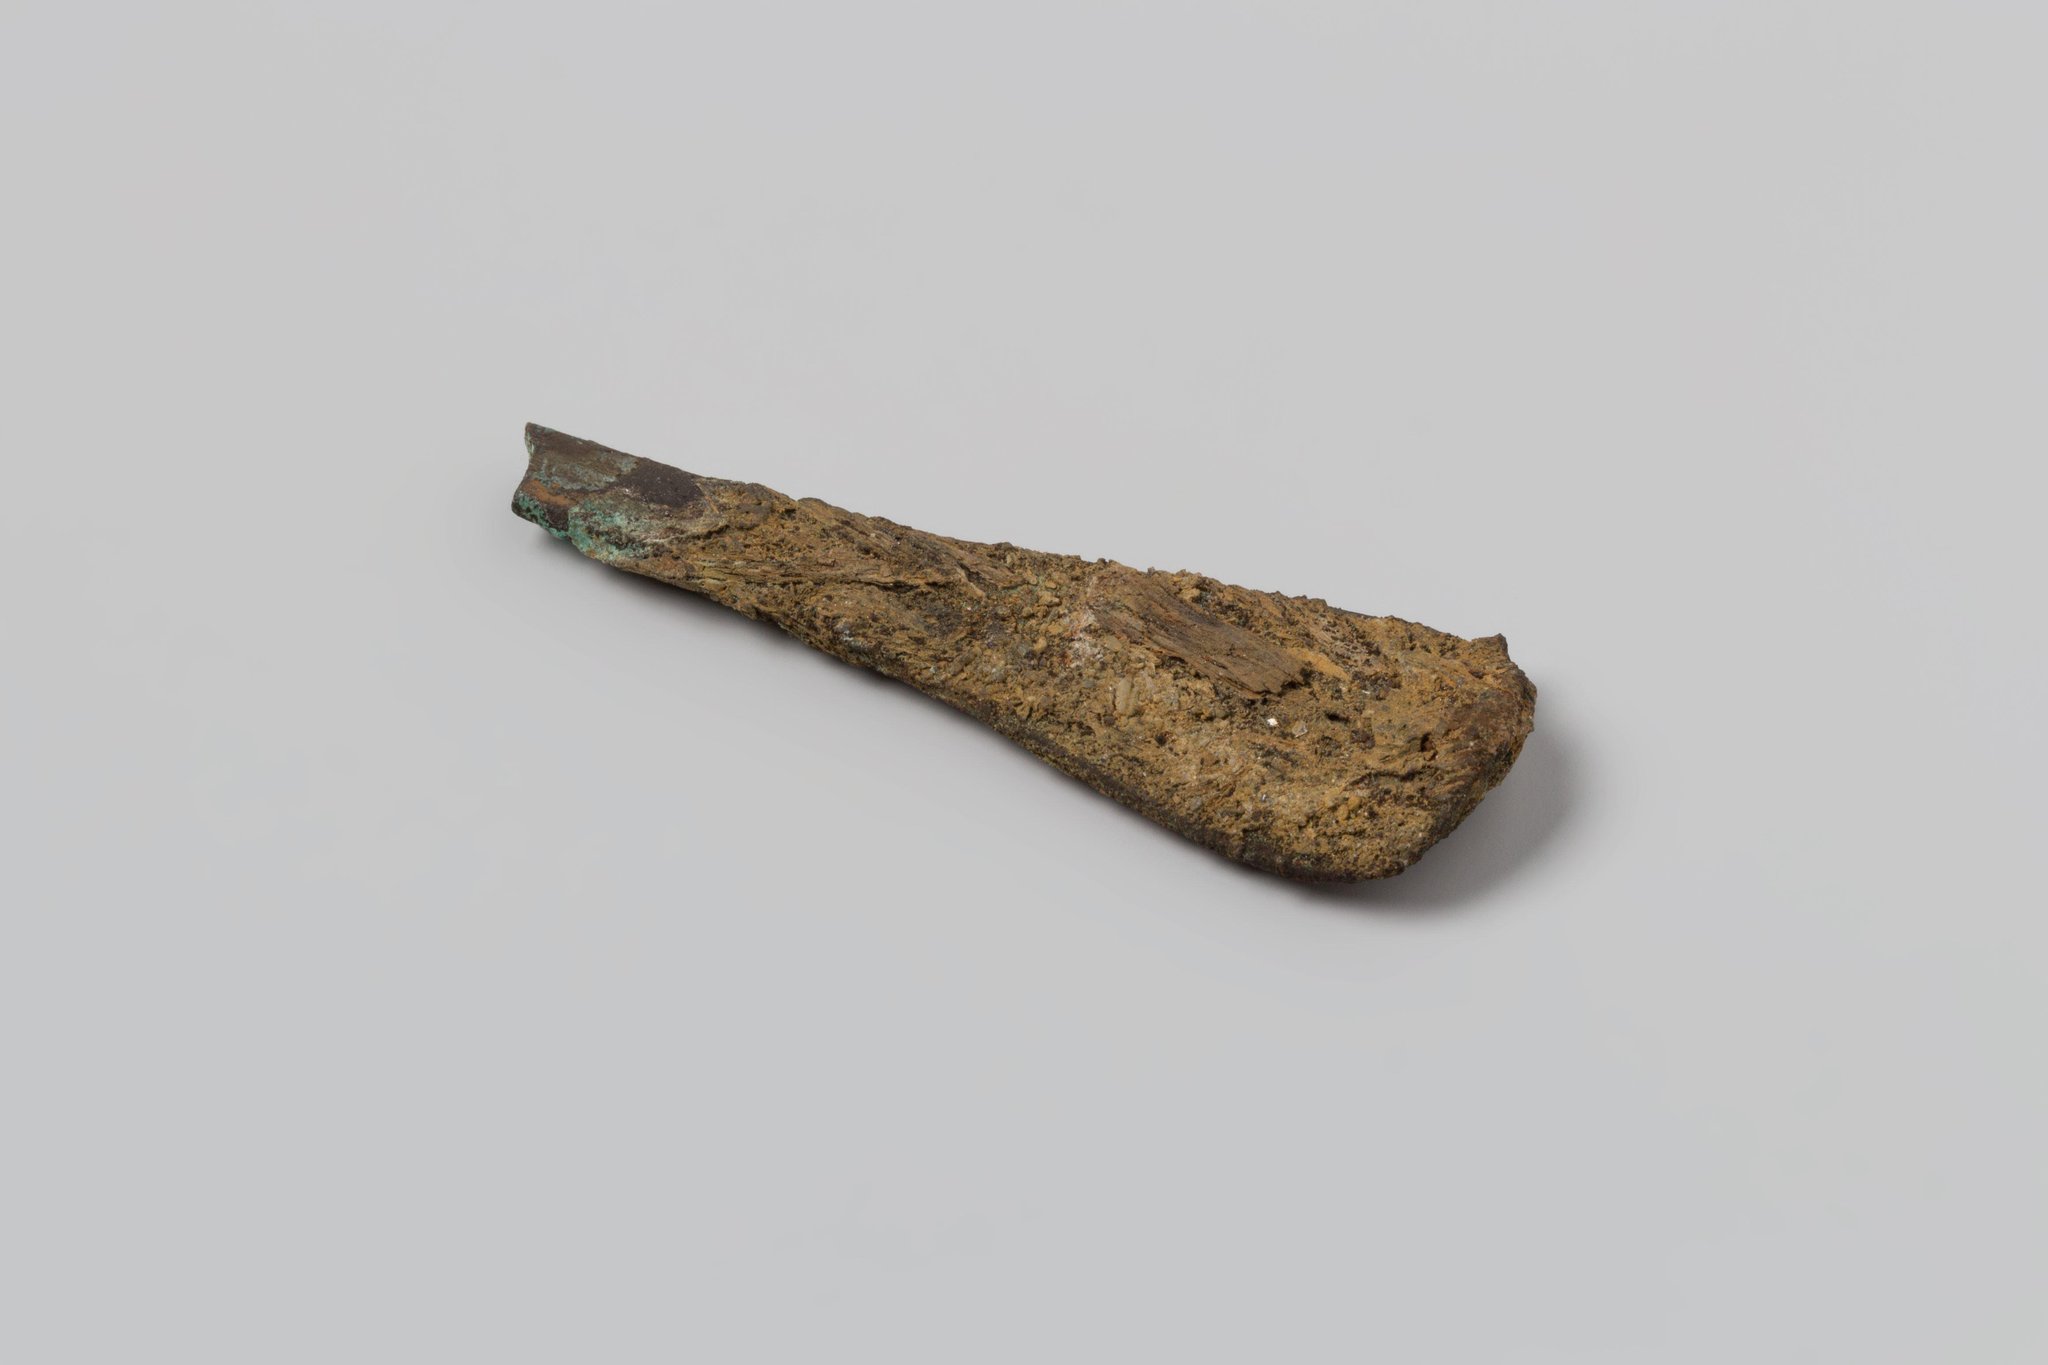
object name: spoon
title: Fragment steel van vork of lepel uit het wrak van de Oost-Indiëvaarder Hollandia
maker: Anonymous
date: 1700-1743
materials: copper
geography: netherlands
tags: verenigde oostindische compagnie, hollandia (schip), annet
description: Cutlery, fragment: stem of fork or spoon; fragm, sim. NG 1980-27H518.